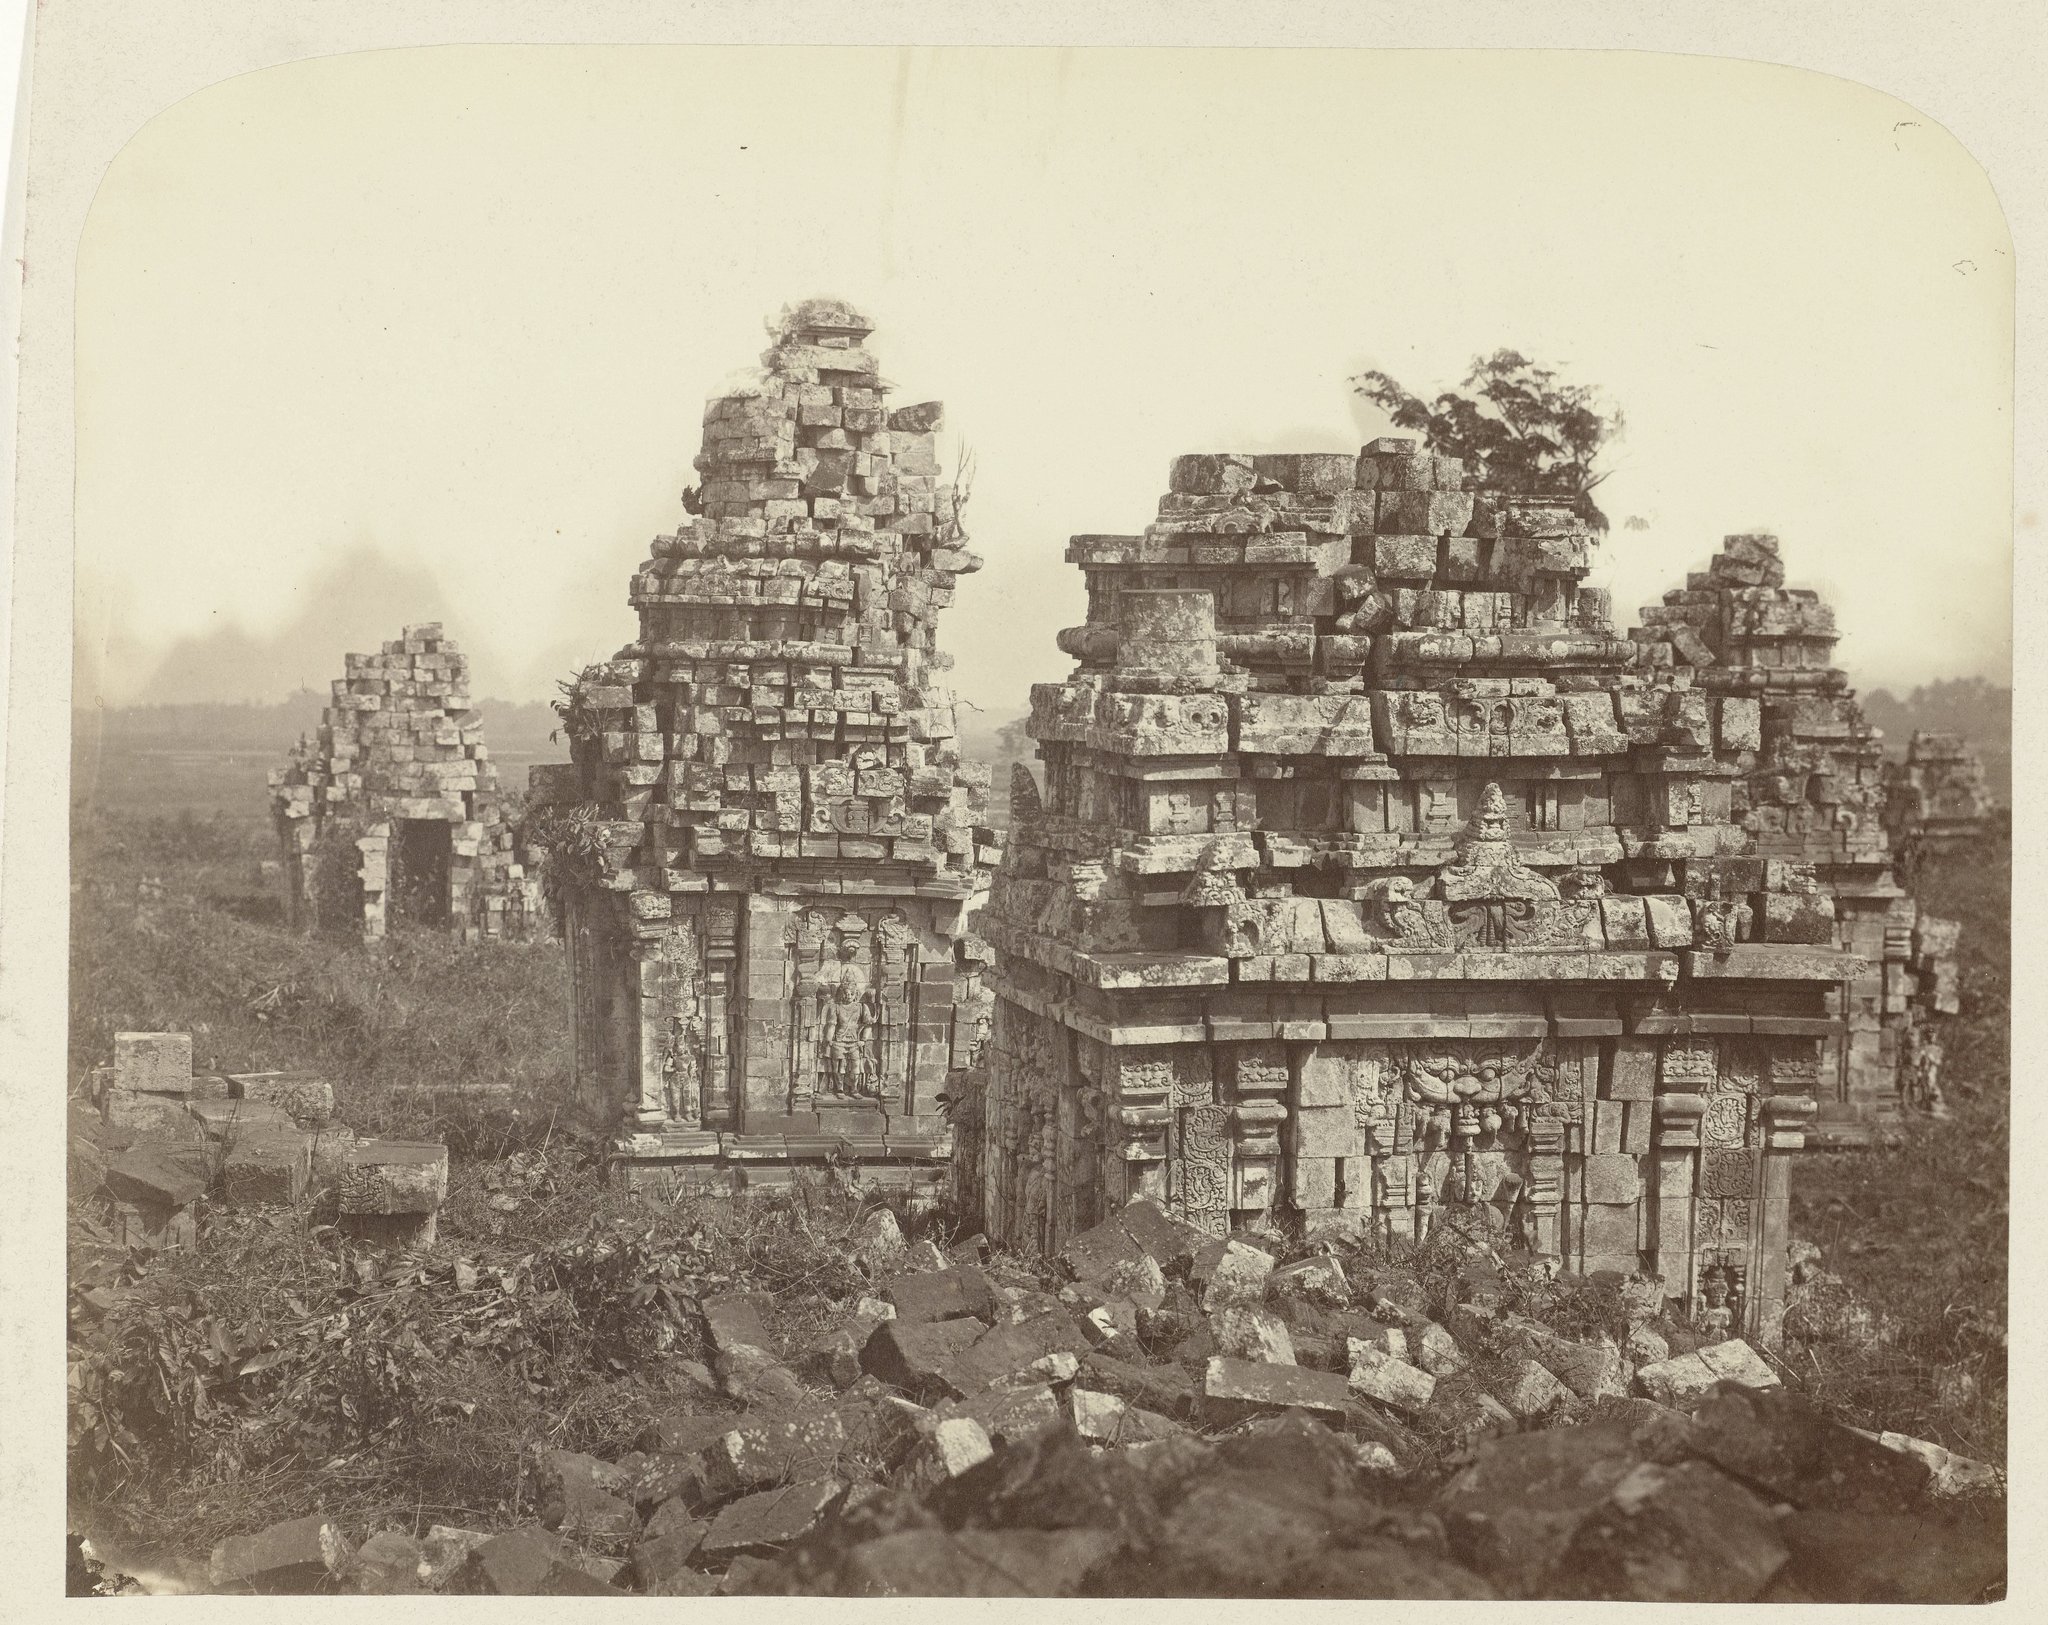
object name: photograph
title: Candi Sewu (Temple complex)(Buddhist) subsidiary temples. Bokoharjo, Yogyakarta district, D.I. Yogyakarta province, 8th -9th century.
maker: isidore kinsbergen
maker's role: fotograaf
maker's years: 1821-1905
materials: cardboard, paper, photographic support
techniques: albumen print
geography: java